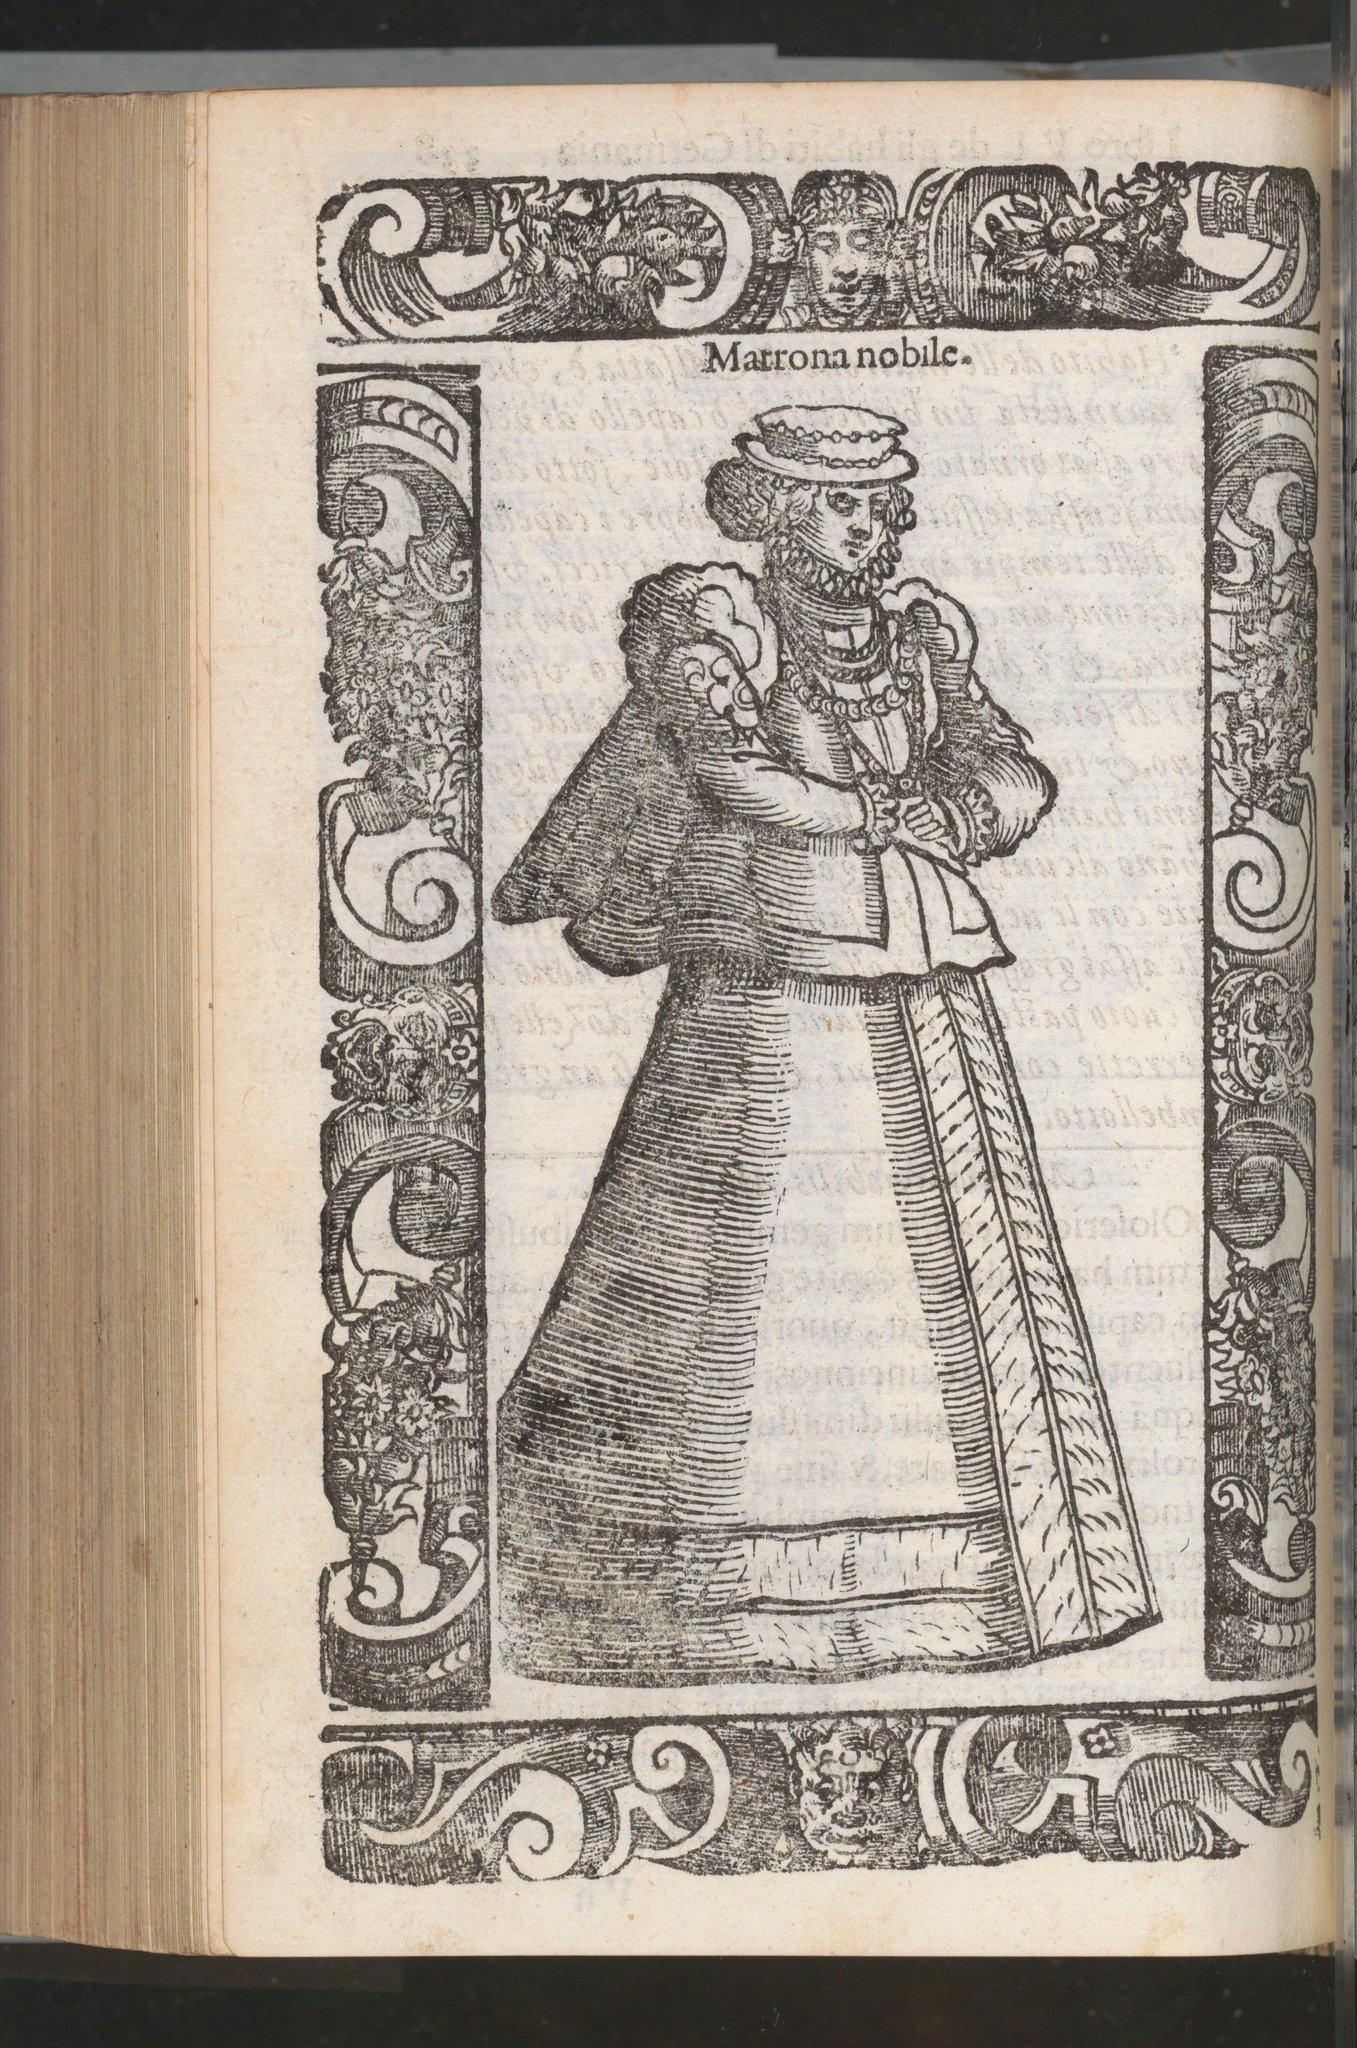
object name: costume print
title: Habiti antichi, et moderni di tutto il mondo...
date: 1598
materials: paper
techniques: woodcut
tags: fashion plates